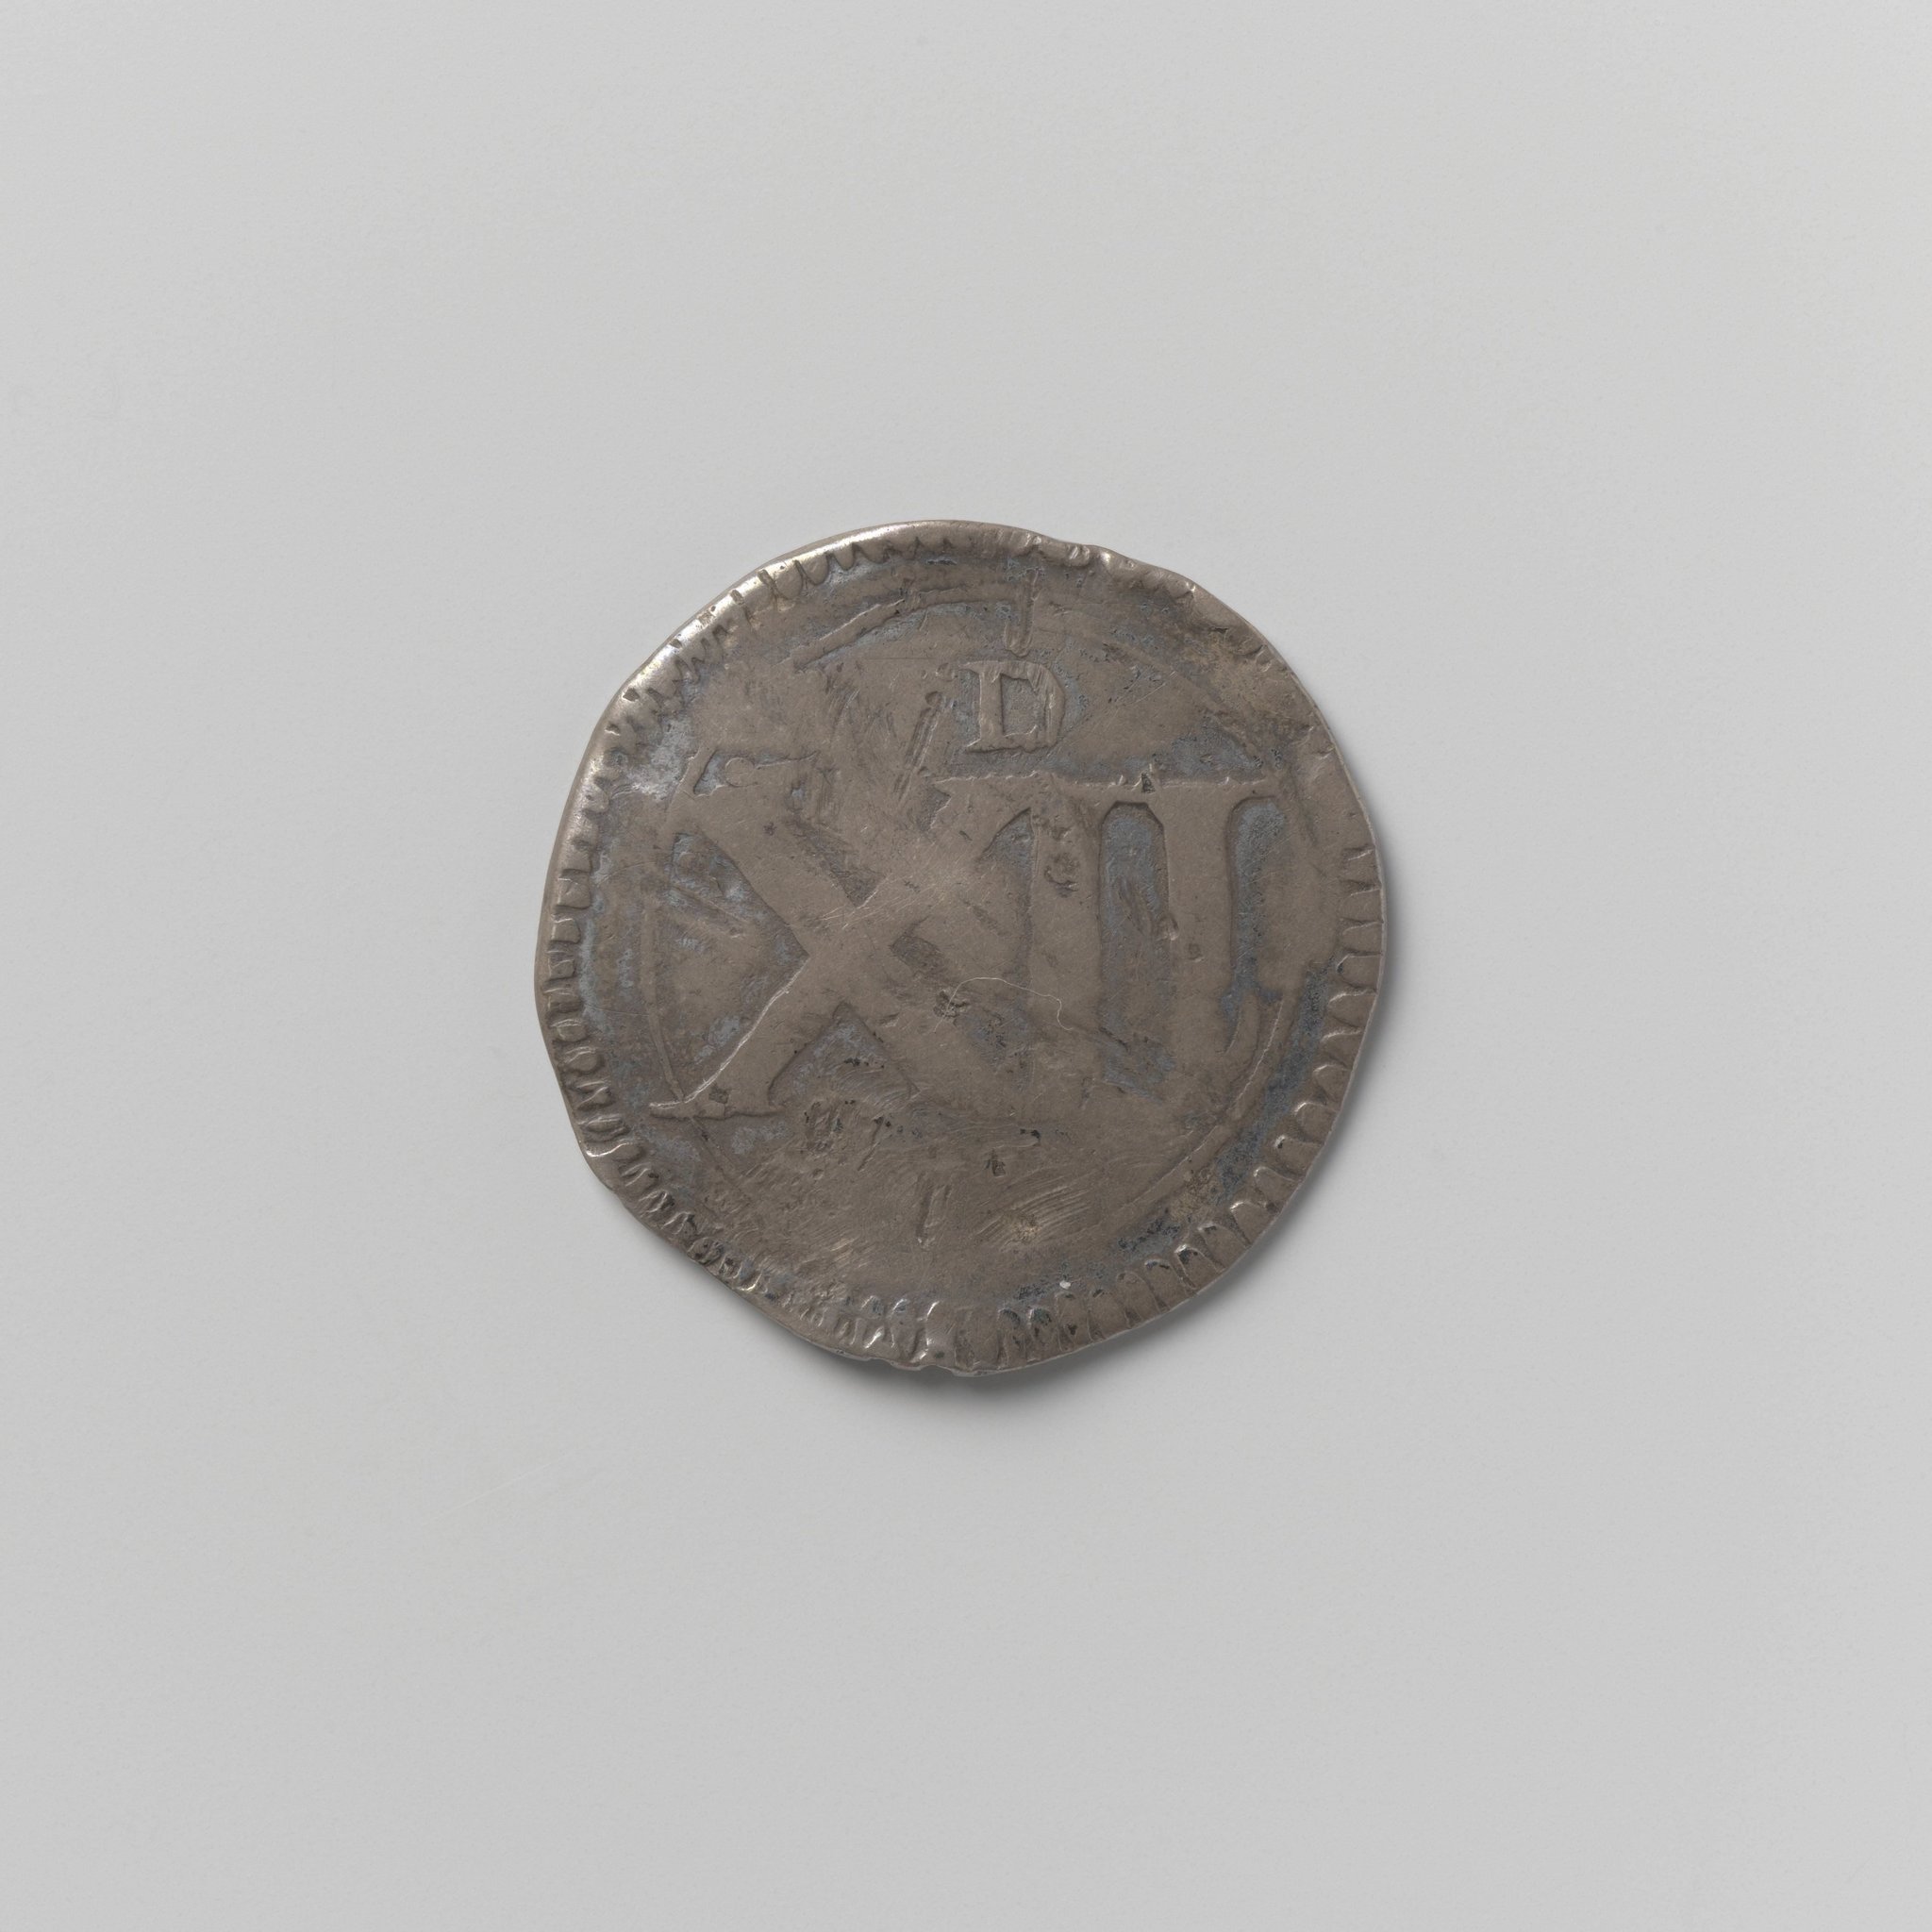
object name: twaalf penny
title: Shilling; twaalf pence, noodmunt van Karel I, koning van Engeland te Ormond geslagen van het door de ingezetenen opgebrachte zilver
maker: Anonymous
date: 1643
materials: silver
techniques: striking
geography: ireland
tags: london, karel i (koning van engeland)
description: Voorzijde: kroon boven letters C en R binnen parelrand. Keerzijde: waardeaanduiding (twaalf pence): Romeins cijfer XII onder letter D binnen parelrand